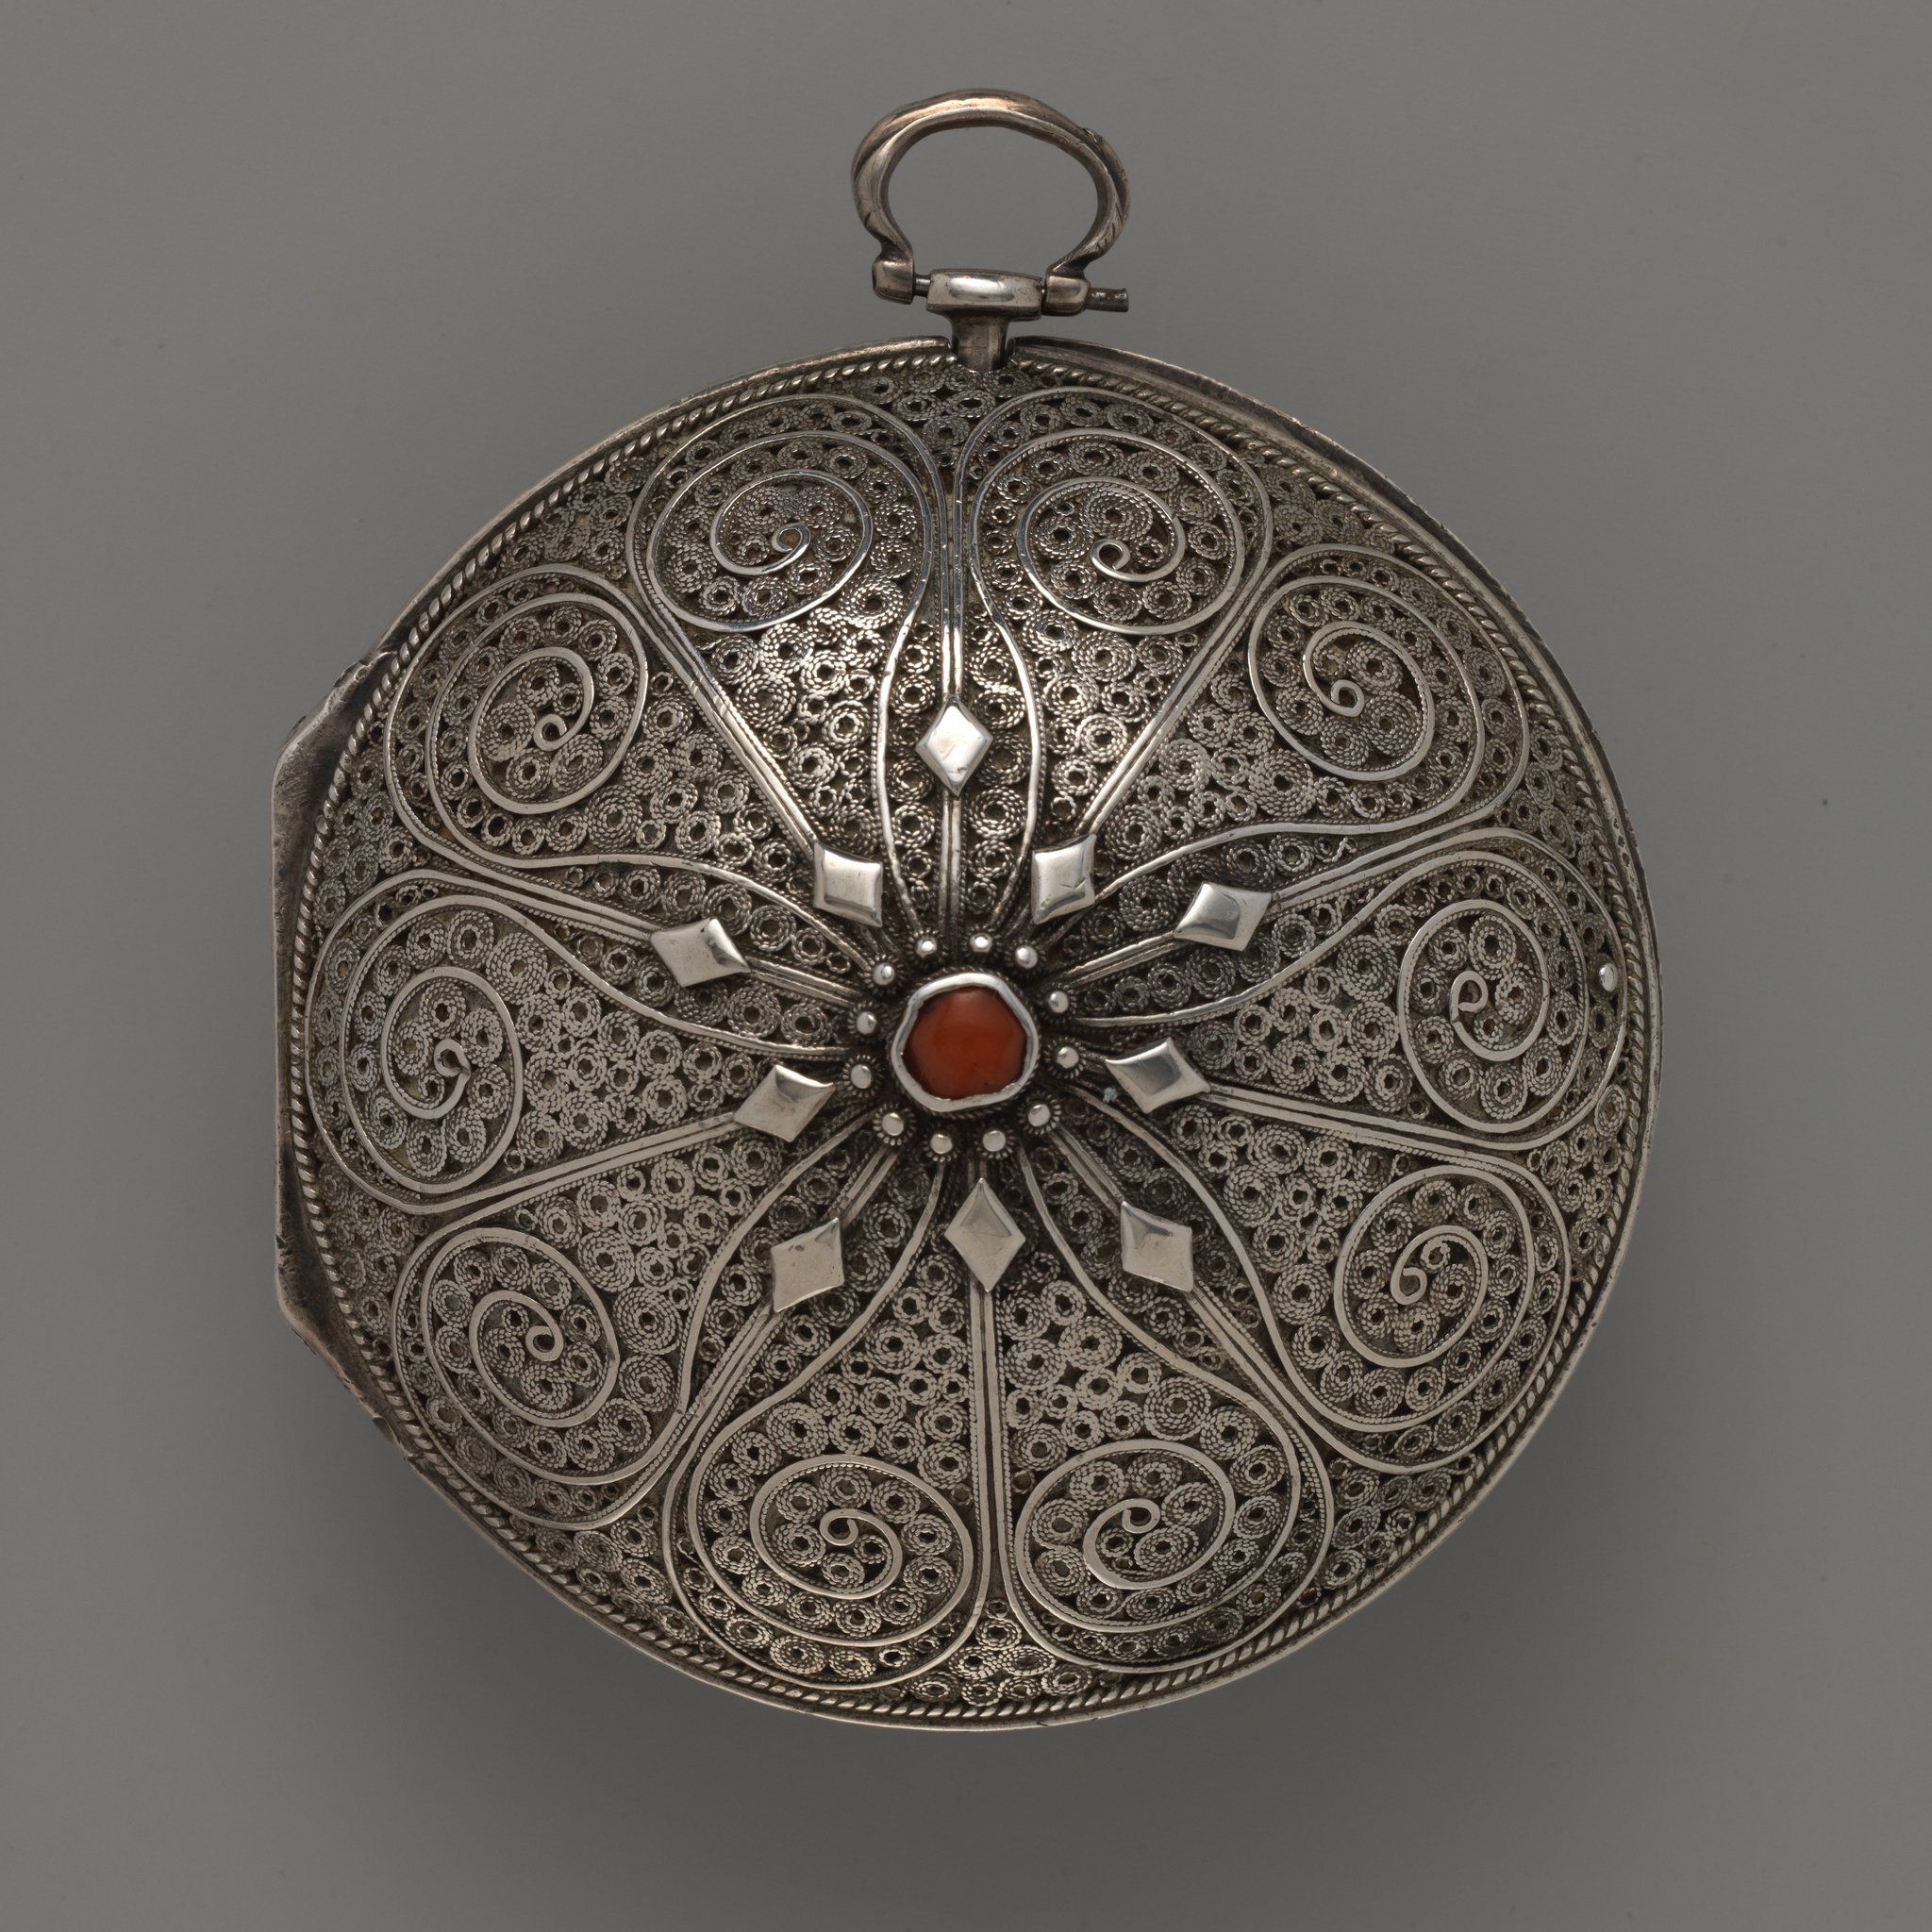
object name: watch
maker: edward prior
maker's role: maker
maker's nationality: british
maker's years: 1800-1868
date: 1801-1900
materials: coral, enamel, silver, shell